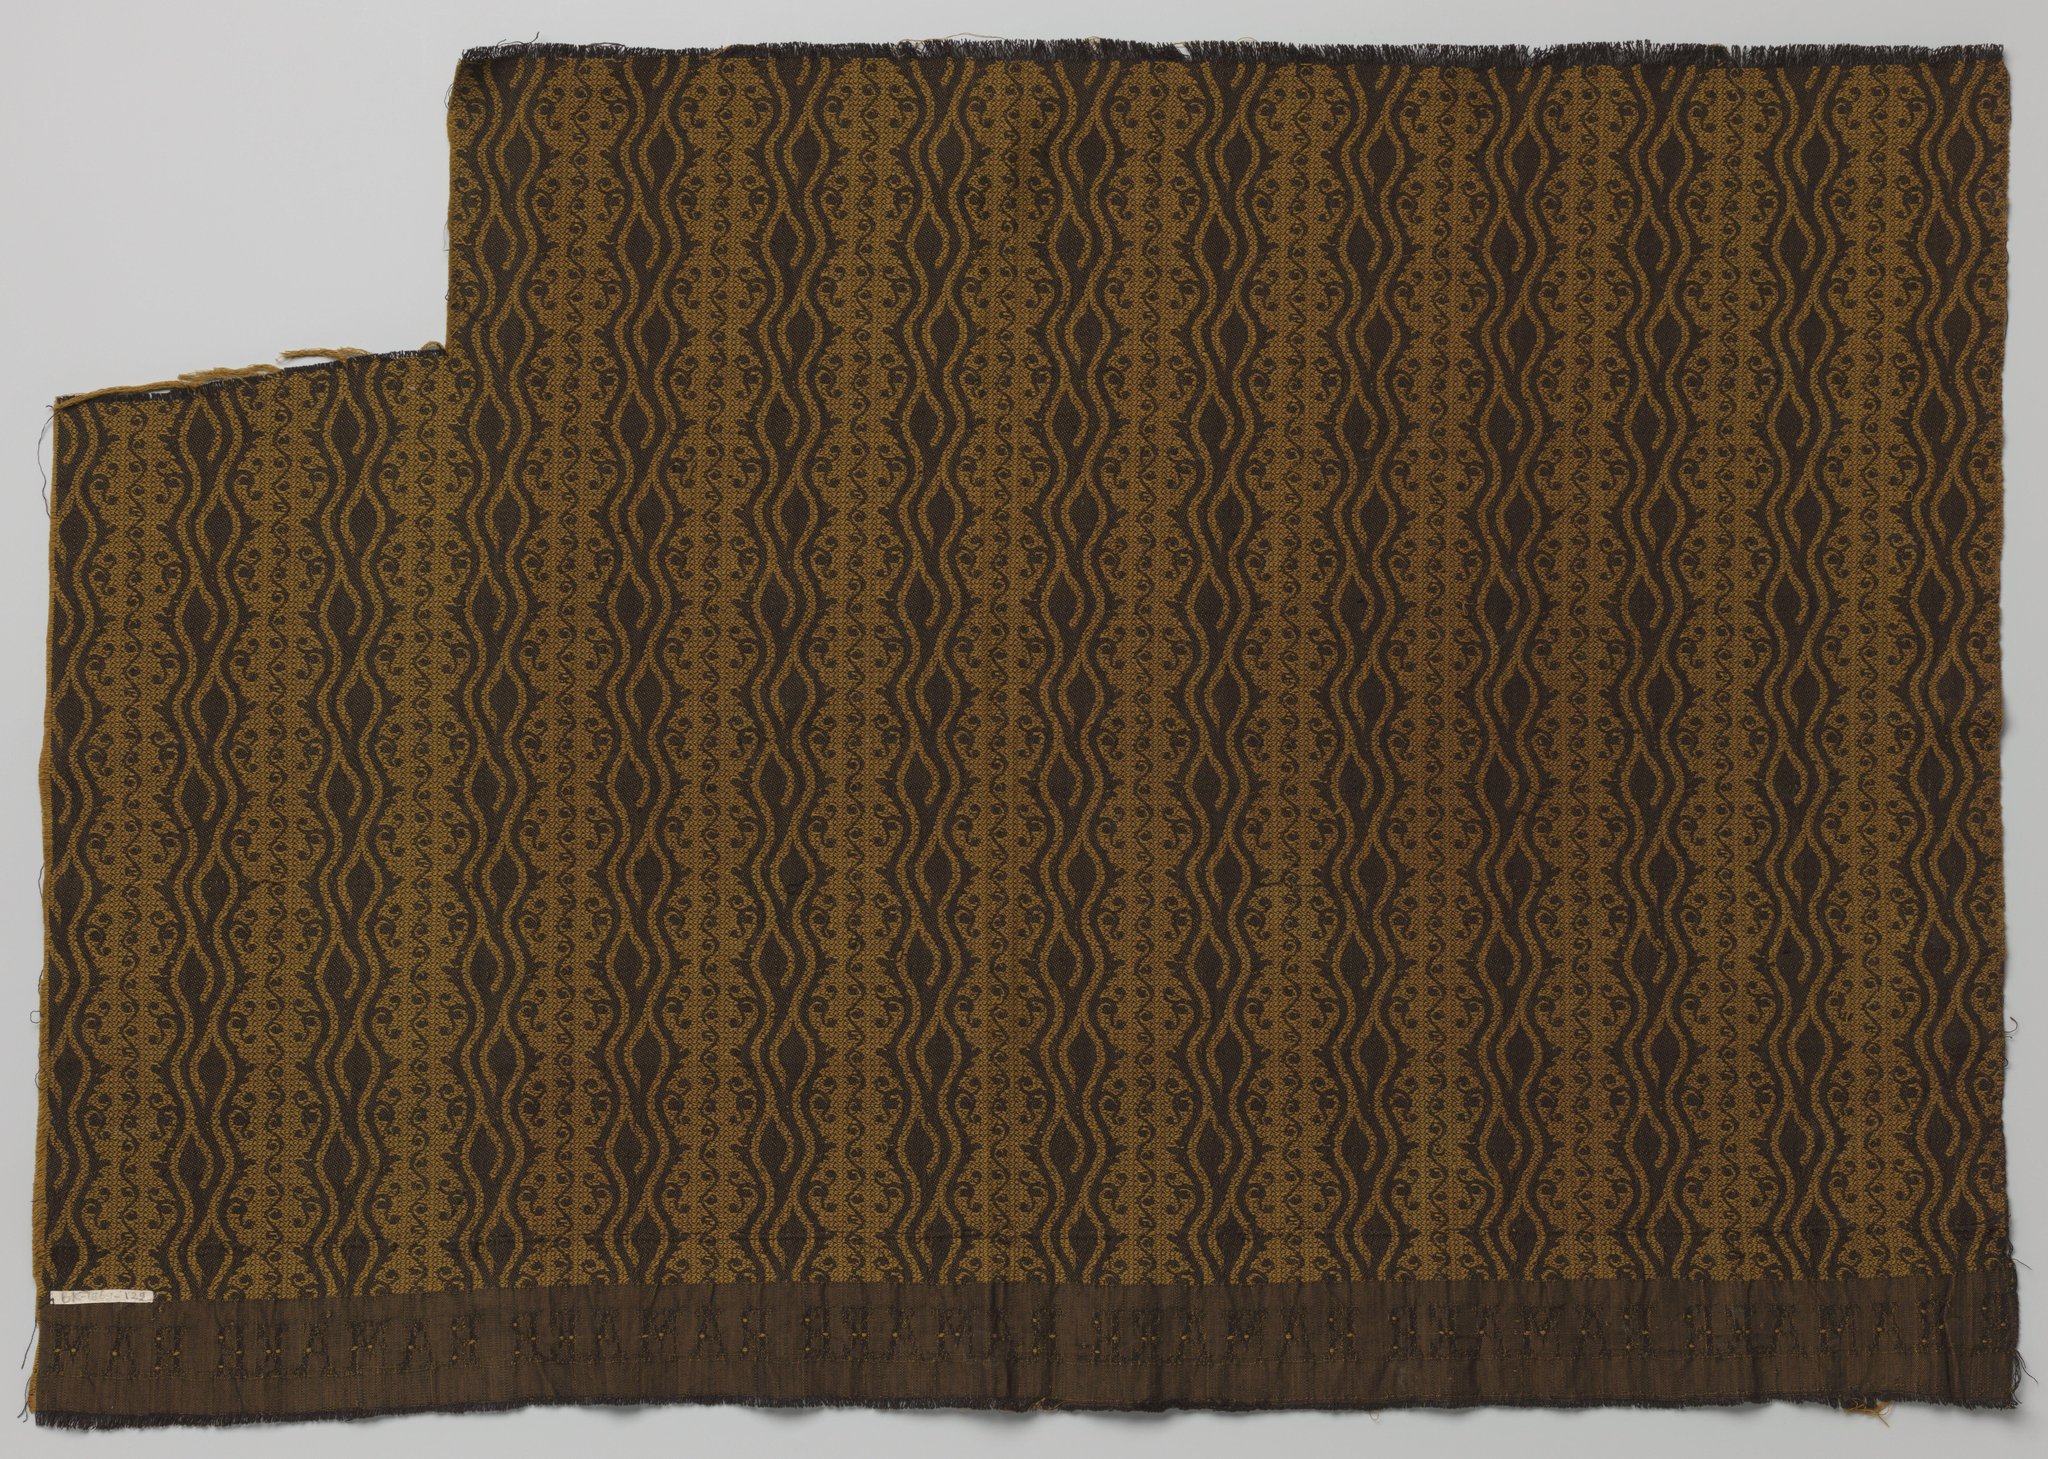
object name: gordijnstof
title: Gordijnstof met geornamenteerde lengtestrepen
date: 1900-1925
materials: cotton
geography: netherlands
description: Gordijnstof met geornamenteerde lengtestrepen. Onderrand met inweving RAMAER. Gele inslag op zwarte ketting. Rechtsboven een gedeelte van 17 x 17 cm. uitgesneden.